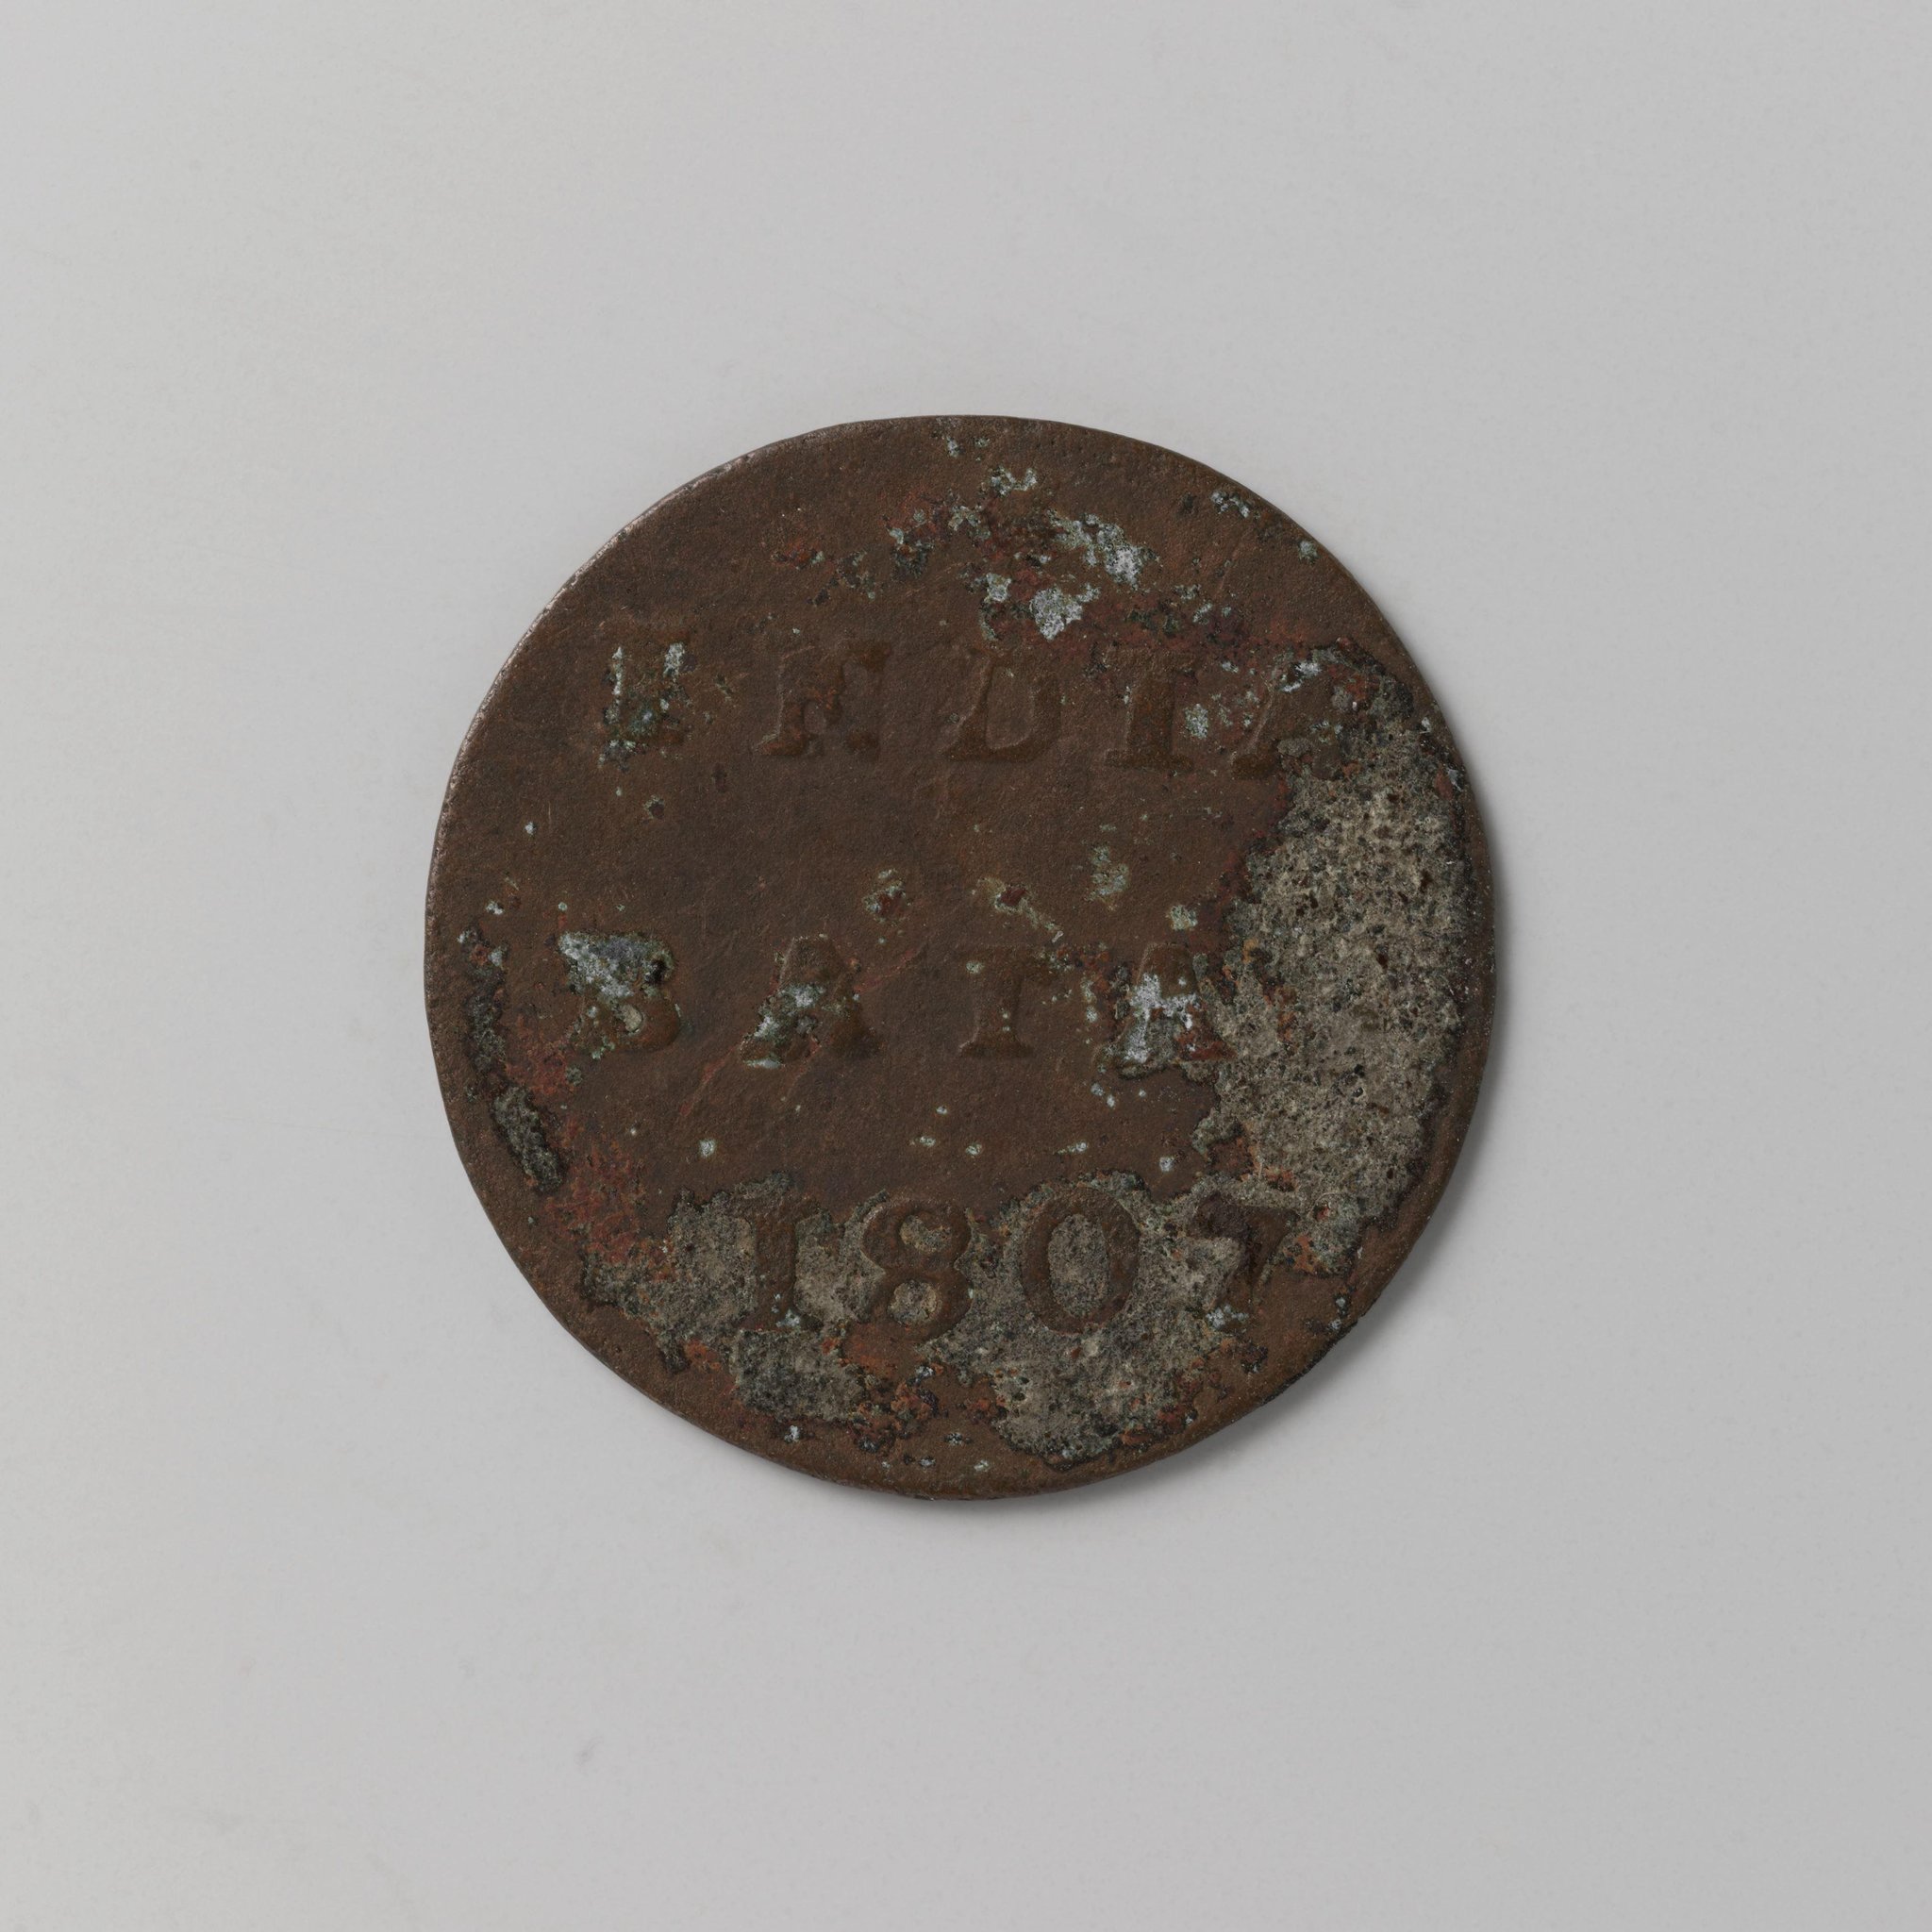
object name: coin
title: Nederlands Indië, ½ duit Holland, 1807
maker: louis napoleon (king of holland)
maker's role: koning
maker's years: 1778-1846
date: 1807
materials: copper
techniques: striking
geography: hoorn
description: Koperen munt. Voorzijde: Tweeregelig opschrift, waarboven muntteken ster en waaronder jaartal. Keerzijde: tussen waarde-aanduiding 5 1/32 G gekroond generaliteitswapenschild. Gladde rand.